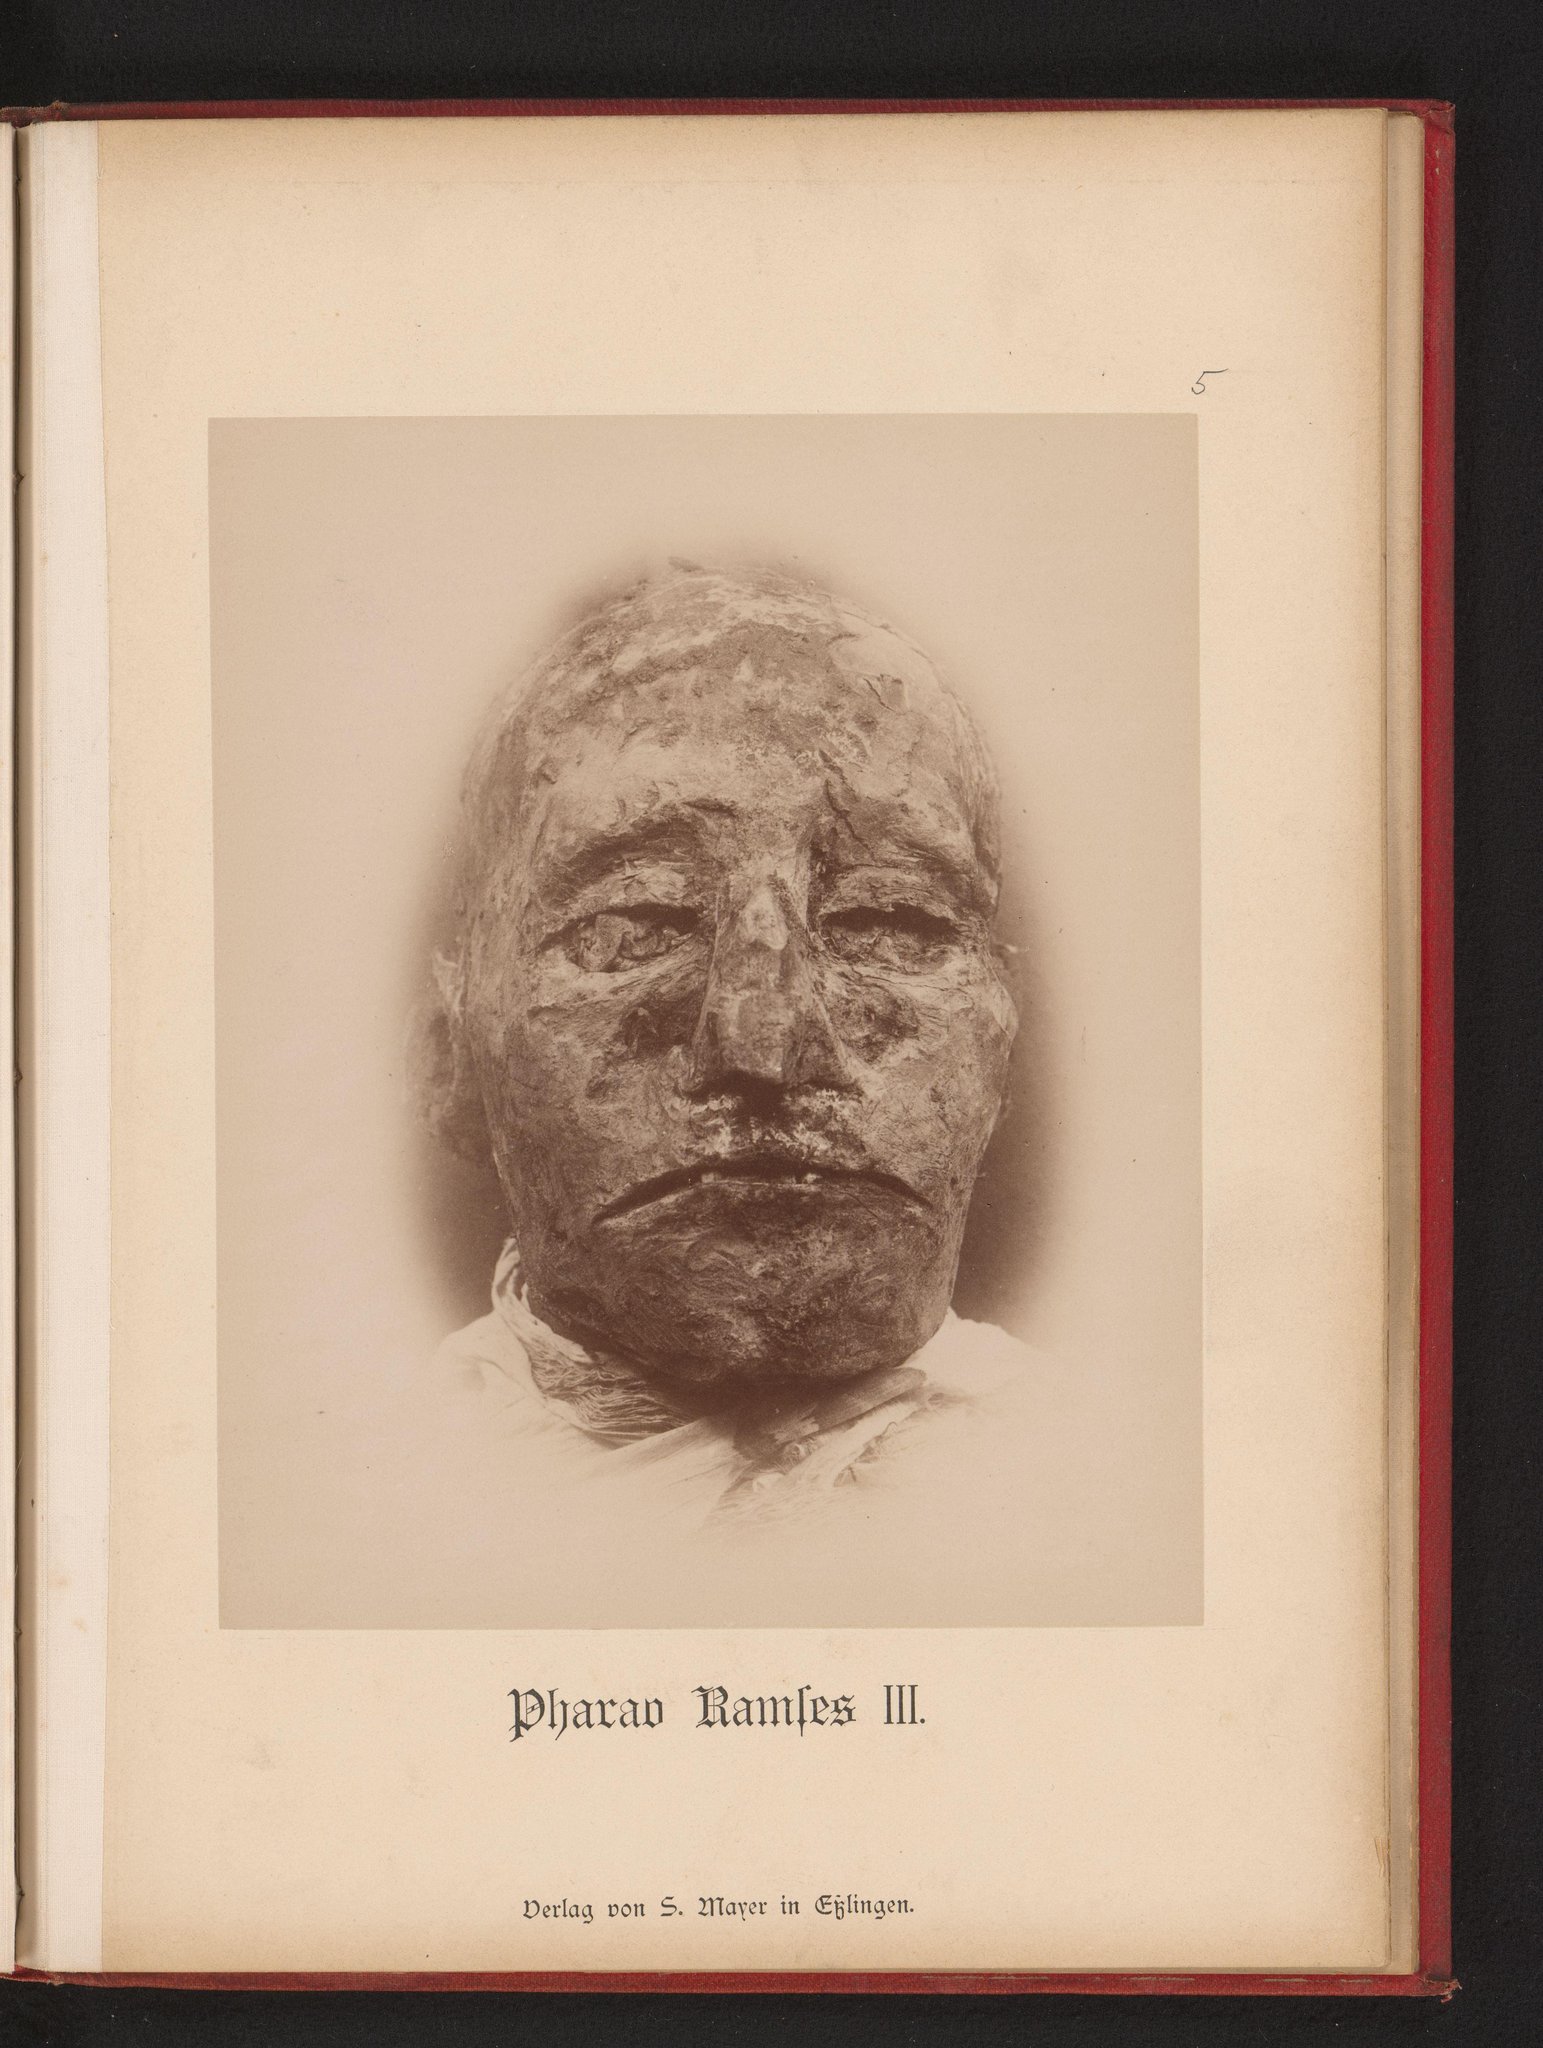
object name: photograph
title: Pharao Ramses III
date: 1886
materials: photographic support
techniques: albumen print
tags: king, mummy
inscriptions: inscription: ‘Verlag von S. Mayer in Esslingen’